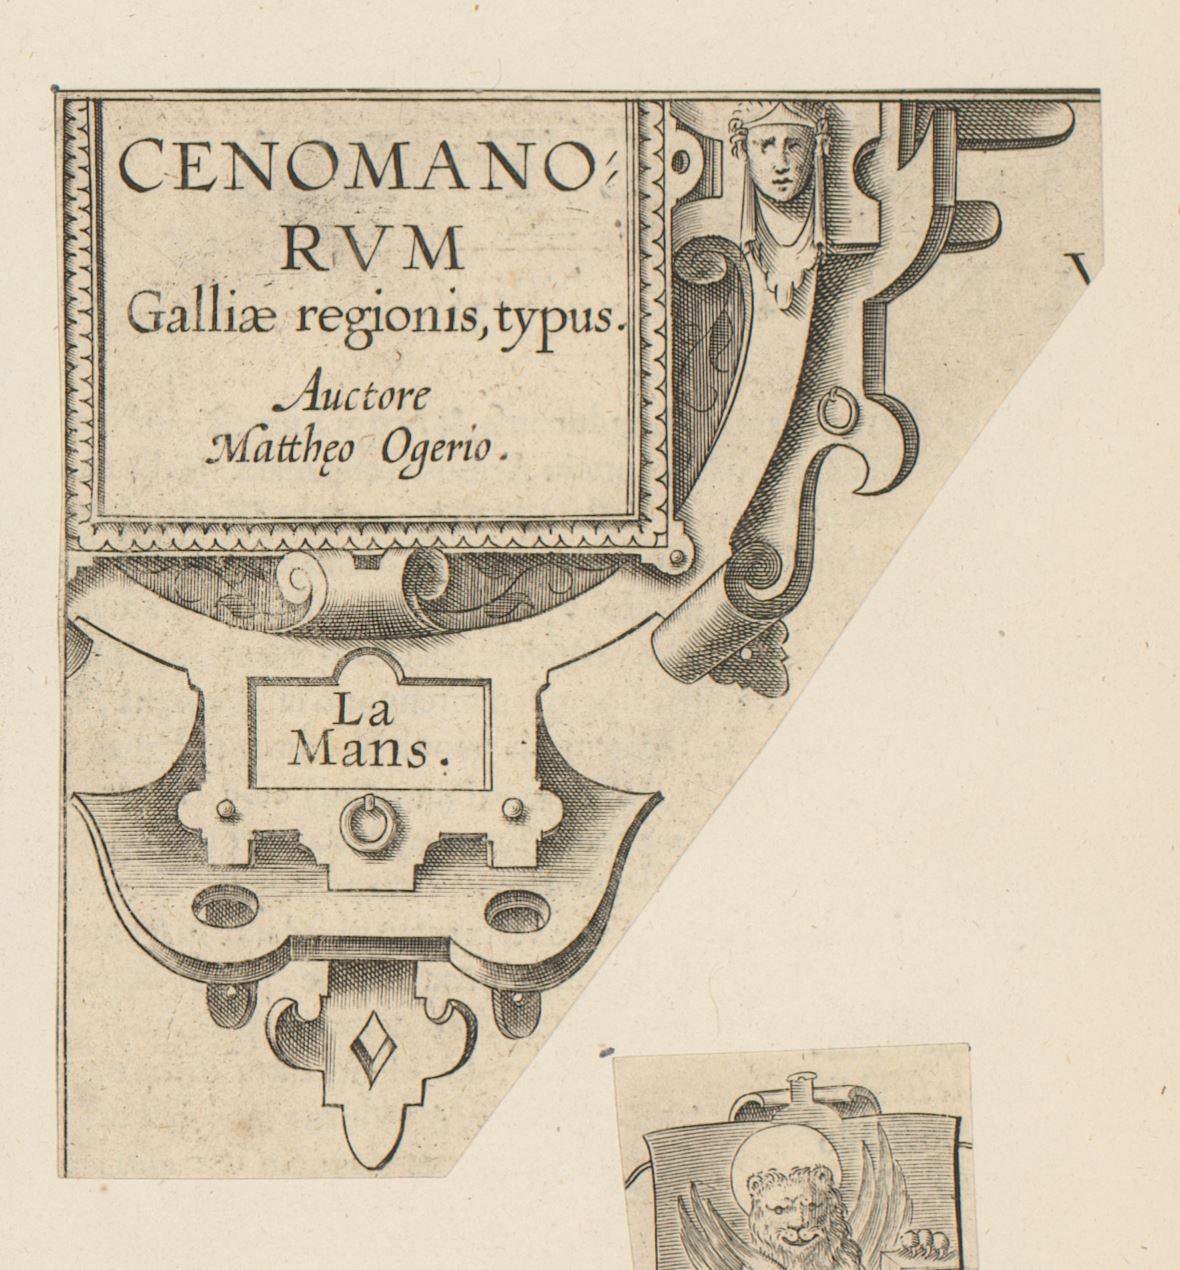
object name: album leaf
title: Theatrum Orbis Terrarum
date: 1595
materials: paper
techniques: engraving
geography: antwerp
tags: ornament ~ cartouche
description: De cartouche is gekopieerd naar een prent van een anonieme graveur naar het ontwerp van Hans Vredeman de Vries, onderdeel van een serie van rolwerkcartouches met grotesken uit circa 1555-1560.